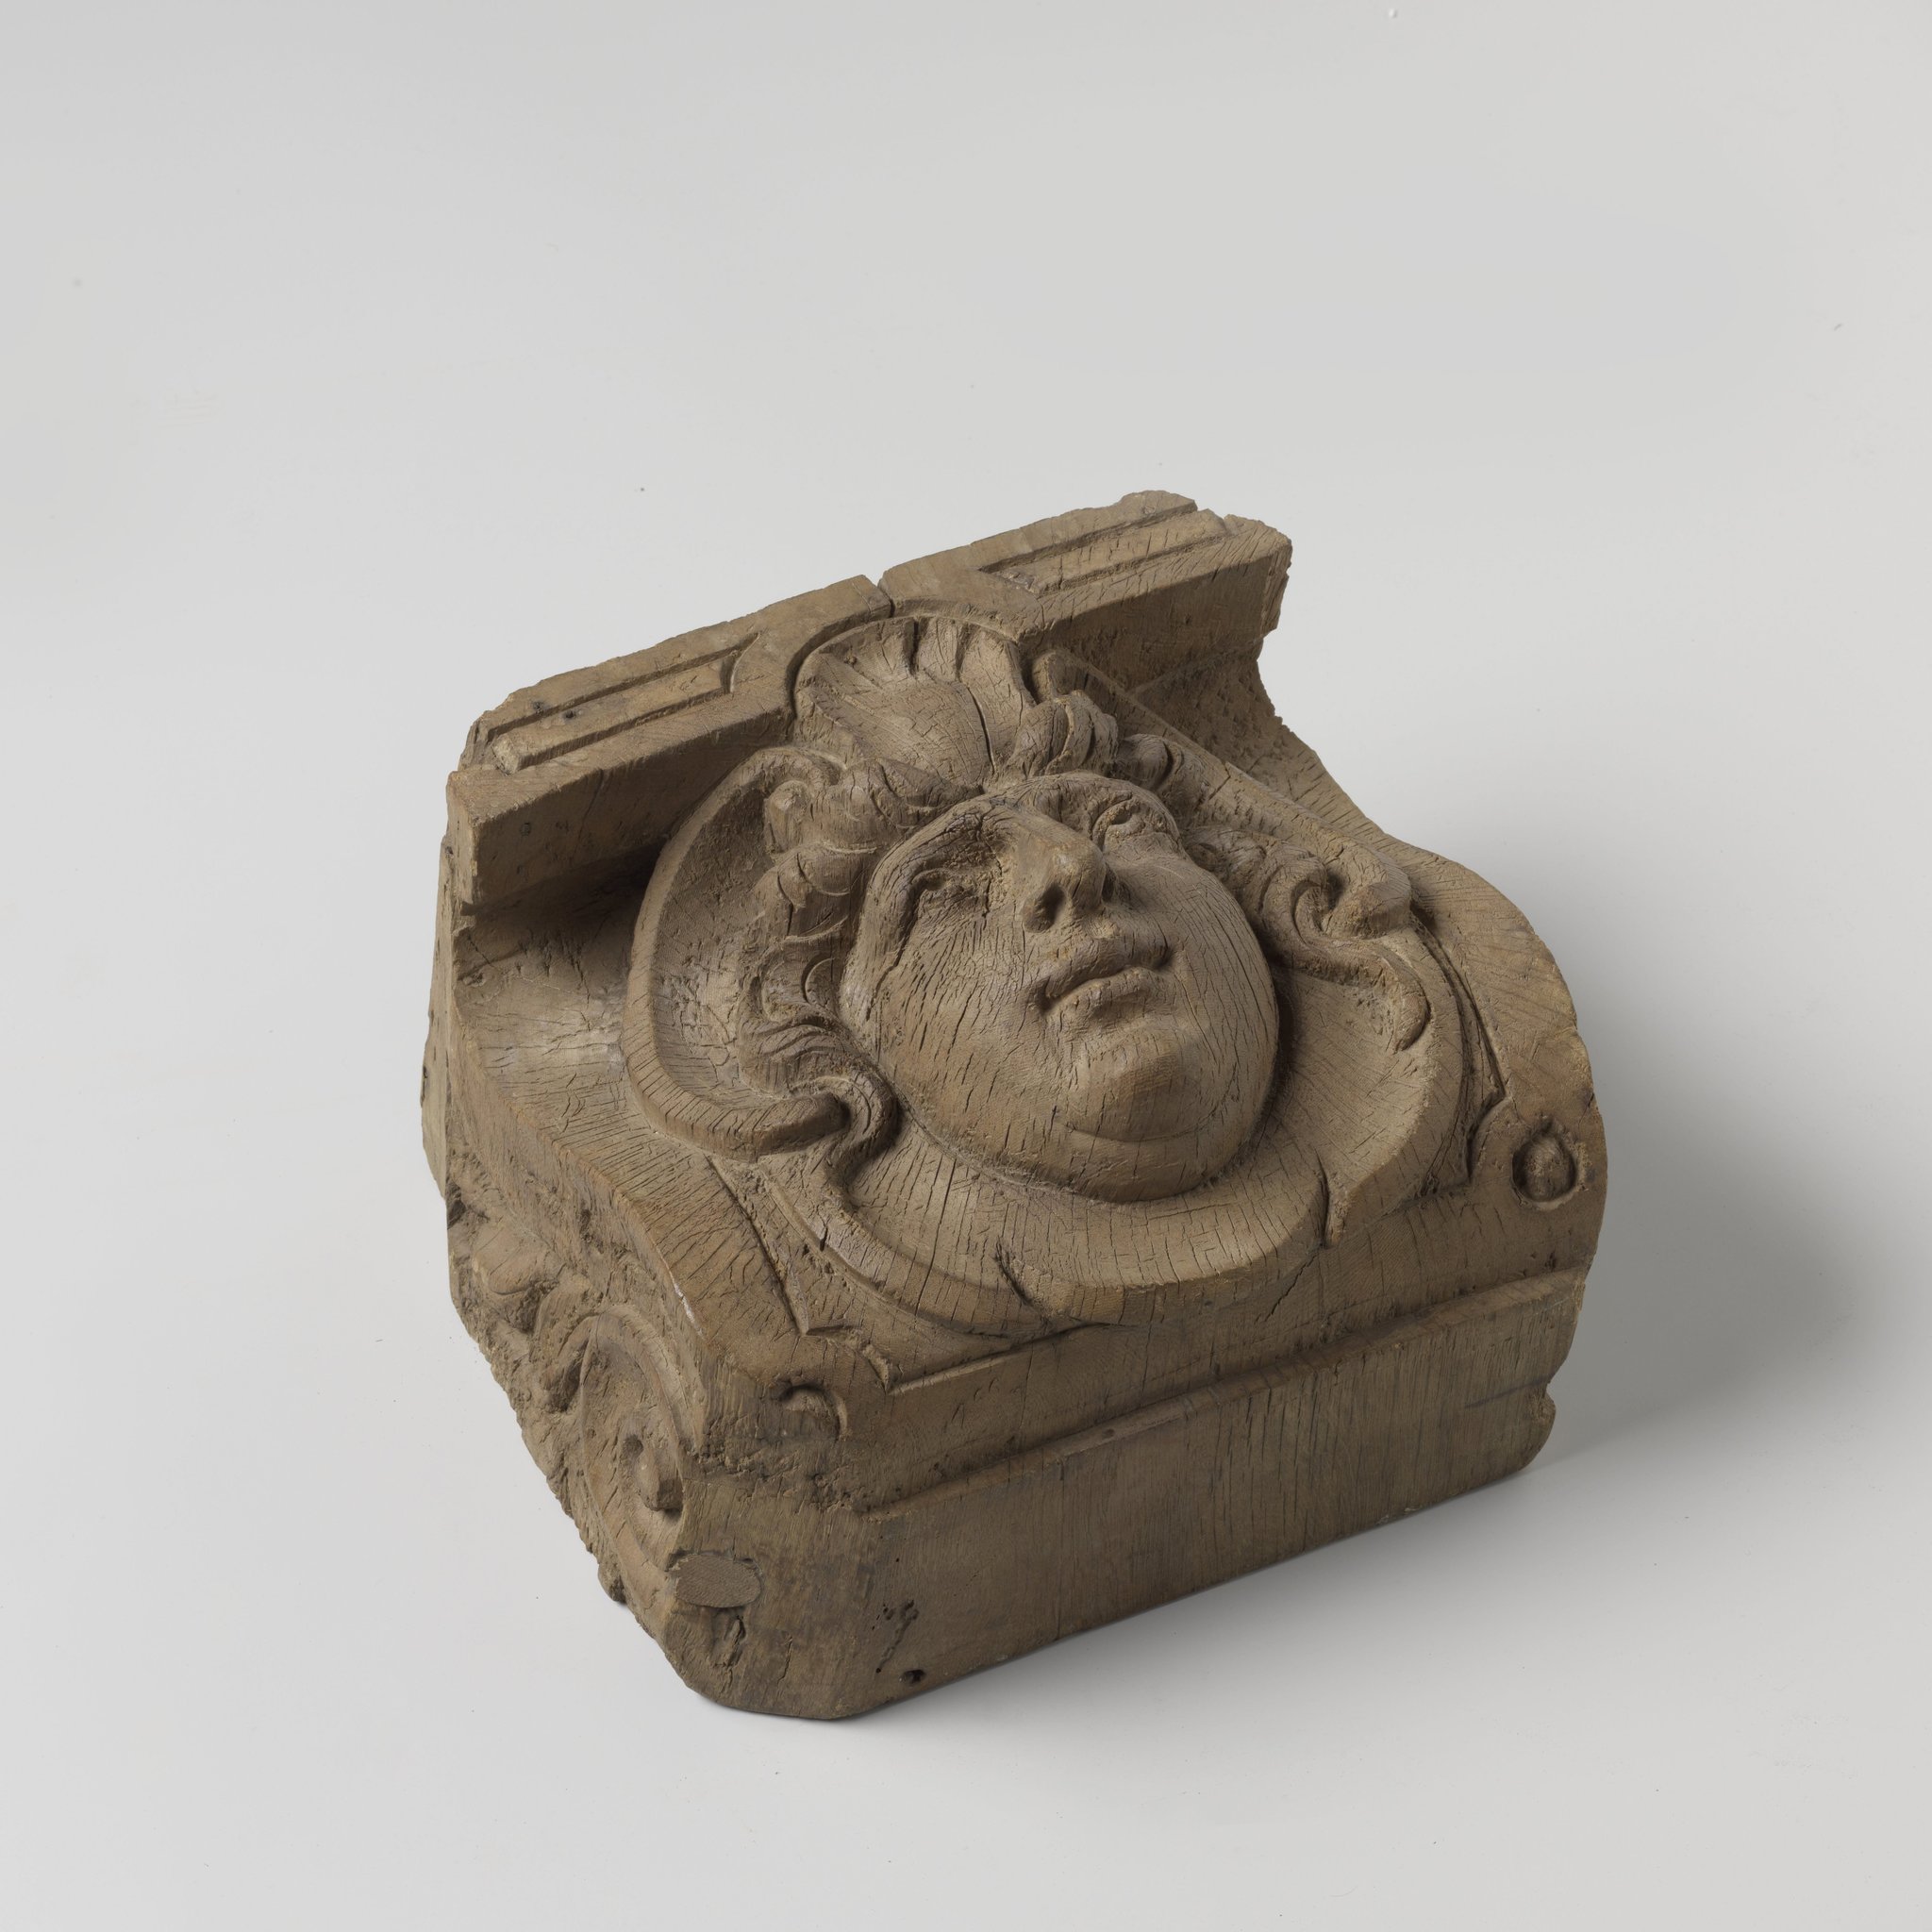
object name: console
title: Gebeeldhouwde console van eikenhout, afkomstig uit het z.g. Huis van Alva, Warmoestraat te Amsterdam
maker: Anonymous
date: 1500-1699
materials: wood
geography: northern netherlands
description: Gebeeldhouwde eikenhouten console, afkomstig uit het z.g. Huis van Alva, Warmoestraat te Amsterdam. In totaal gaat het om twee consoles, drie brede en drie smalle stijlen (BK-KOG-755-A t/m E, G t/m H). Zie tevens BK-KOG-754-1 t/m 7, dit zijn 6 beschilderde stijlen die uit hetzelfde huis afkomstig zijn.